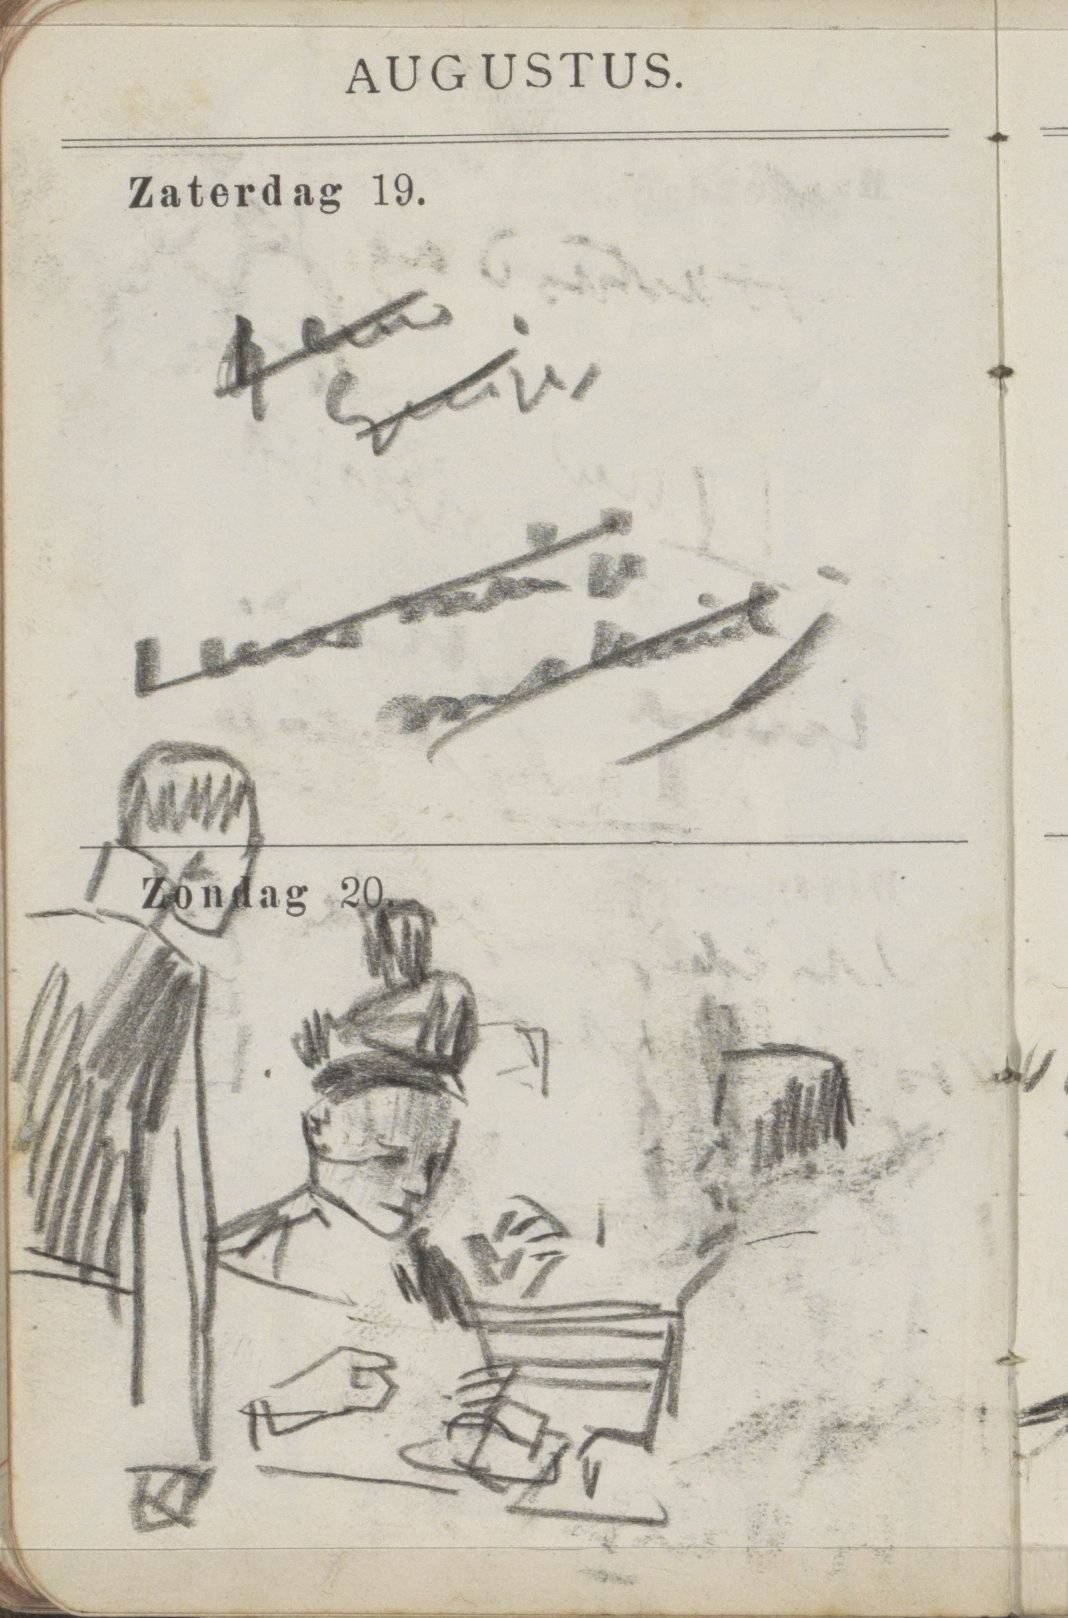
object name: sketchbook leaf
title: Figuren, mogelijk in een etablissement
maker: george hendrik breitner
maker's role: draughtsman, painter, print maker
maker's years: 1857-1923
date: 1893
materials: chalk, paper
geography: amsterdam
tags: sitting figure, sitting figure - aa - female human figure, inn, coffee-house, public house, etc., waiting at table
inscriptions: annotation: ‘1 uur/ Geesje [doorgestreept]/ [...]’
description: Links mogelijk een ober. Pagina 139 uit een als schetsboek gebruikte agenda met 108 bladen.